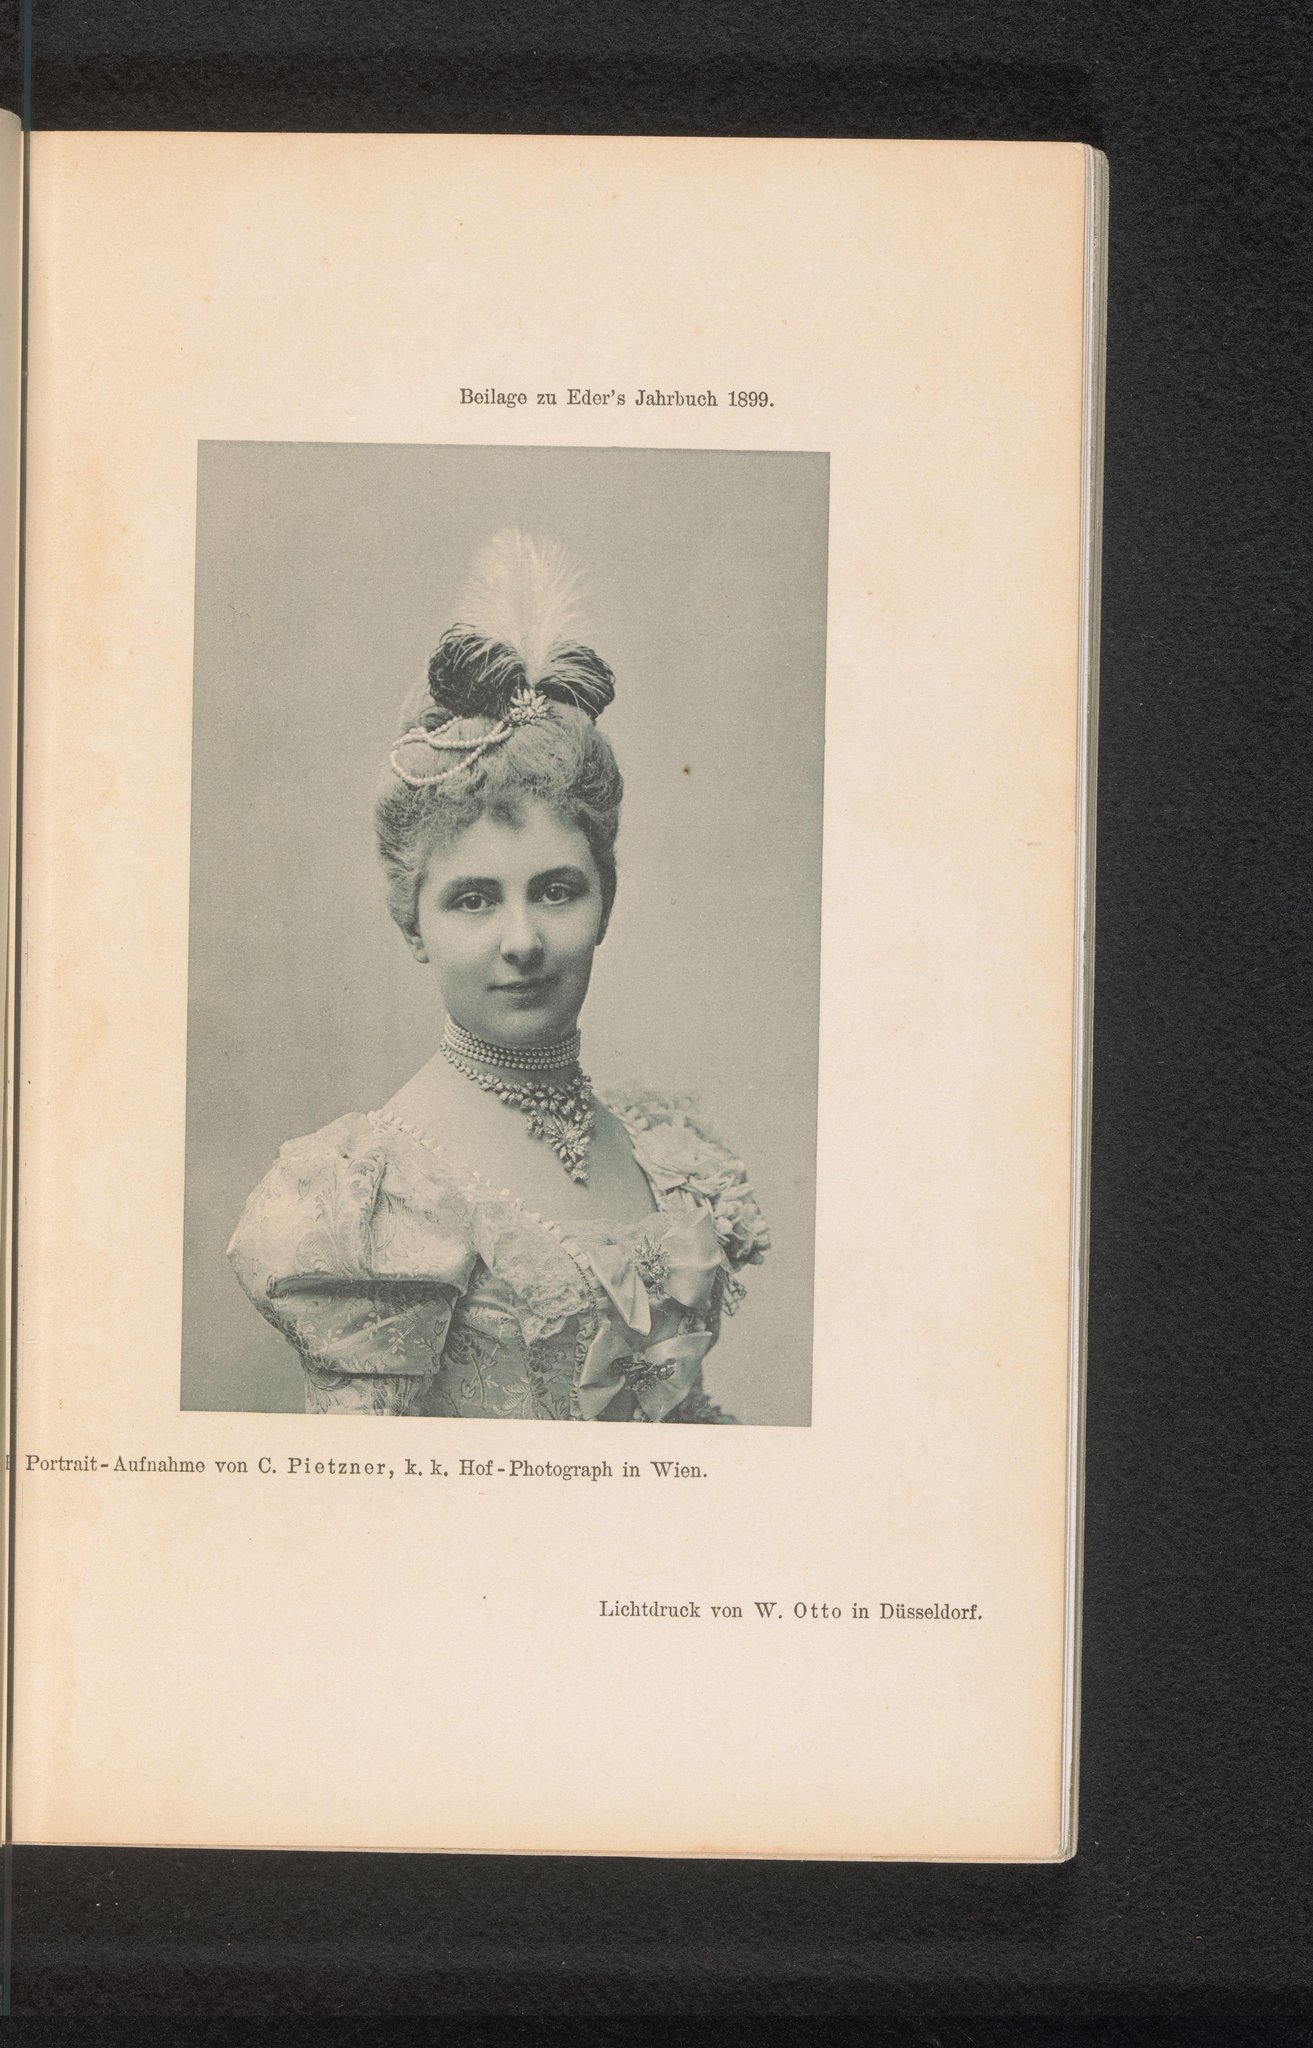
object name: photomechanical print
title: Portret van een onbekende vrouw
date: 1894-1899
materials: paper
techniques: photograph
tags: adult woman, historical persons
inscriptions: inscription: ‘Beilage zu Eder's Jahrbuch 1899.’